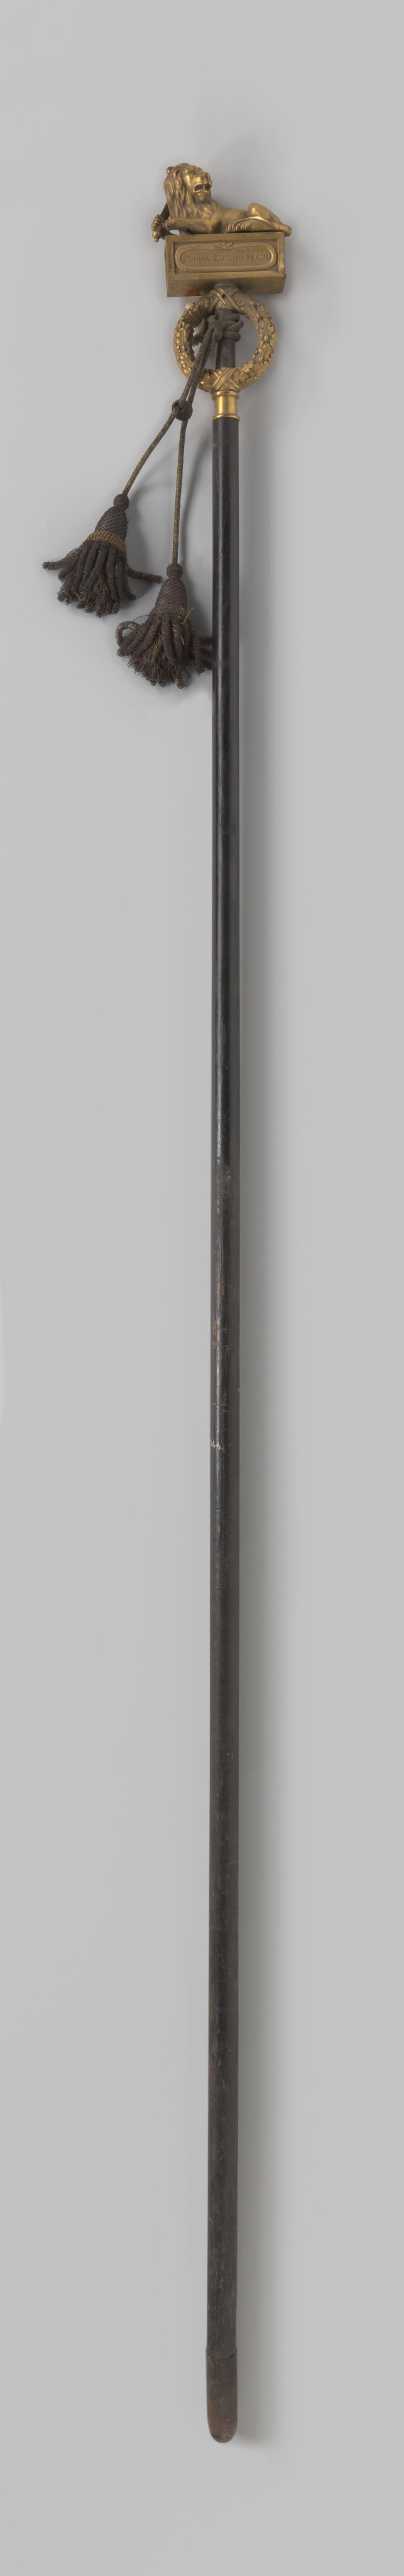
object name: stok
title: Stok van een vaandel van het vijfde afdeling infanterie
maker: jan willem pieneman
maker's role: draughtsman, painter, print maker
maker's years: 1779-1853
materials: bronze, galloon, wood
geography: netherlands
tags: netherlands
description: Stok van zwart gelakt hout, waarop een verguld bronzen krans van eiketakken, en op de top een liggende leeuw met pijlenbundel en zwaard op een dito blok, waarop aan de lange kanten de tekst: KONING EN VADERLAND, omgeven door een slang, en op de korte kanten en gekroonde W.